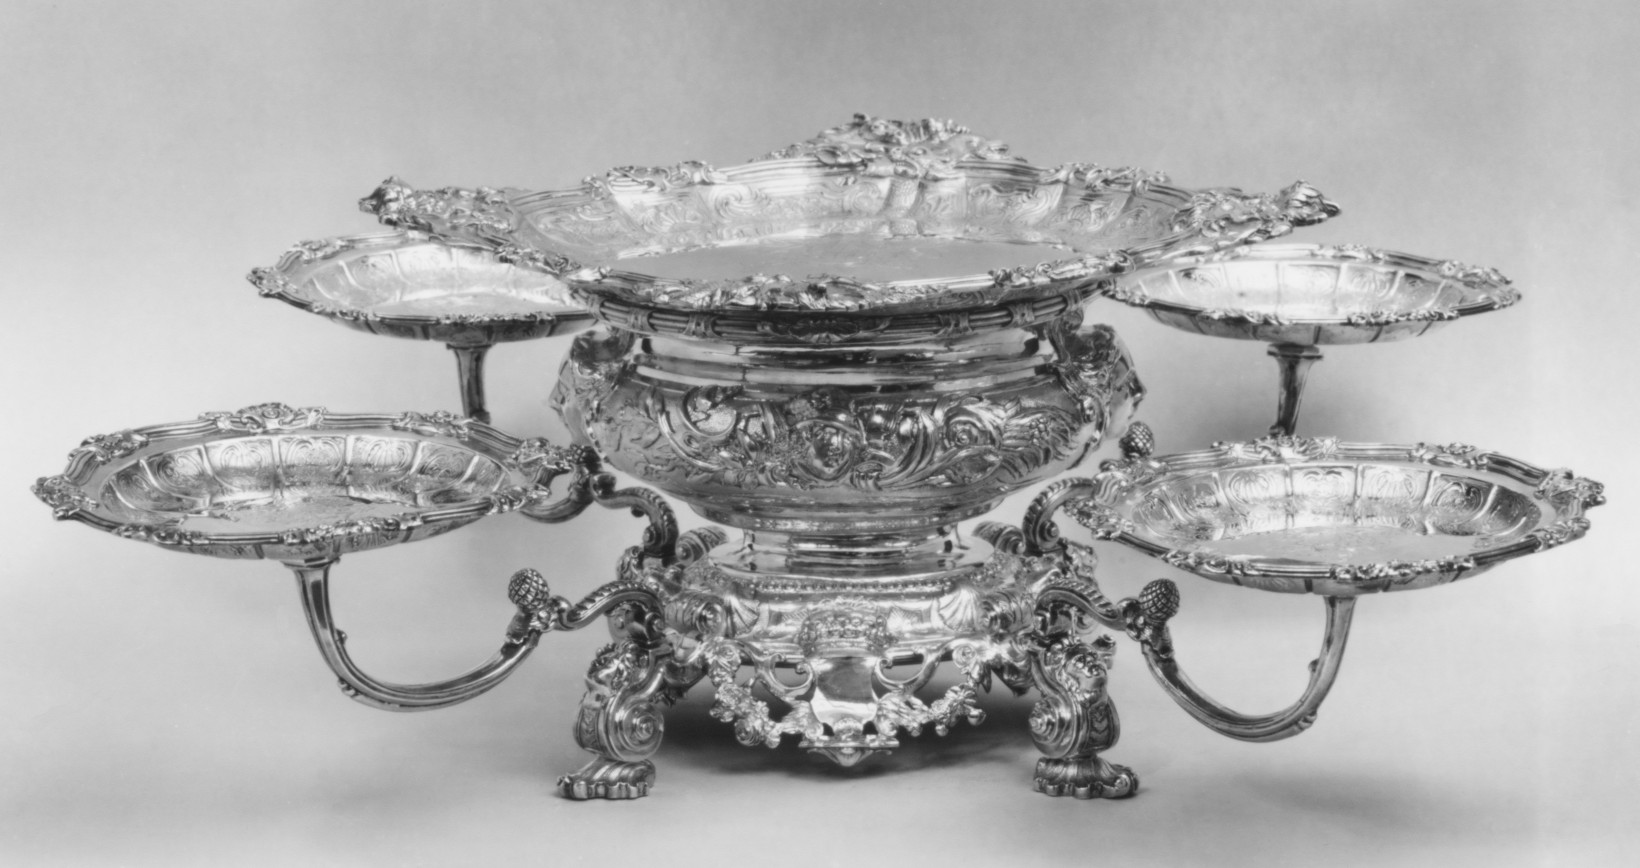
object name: epergne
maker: paul de lamerie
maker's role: maker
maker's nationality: british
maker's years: 1688-1751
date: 1738-1739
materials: silver